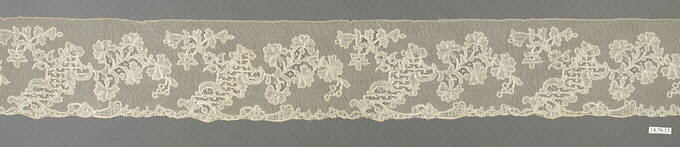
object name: strip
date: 1701-1800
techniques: lace